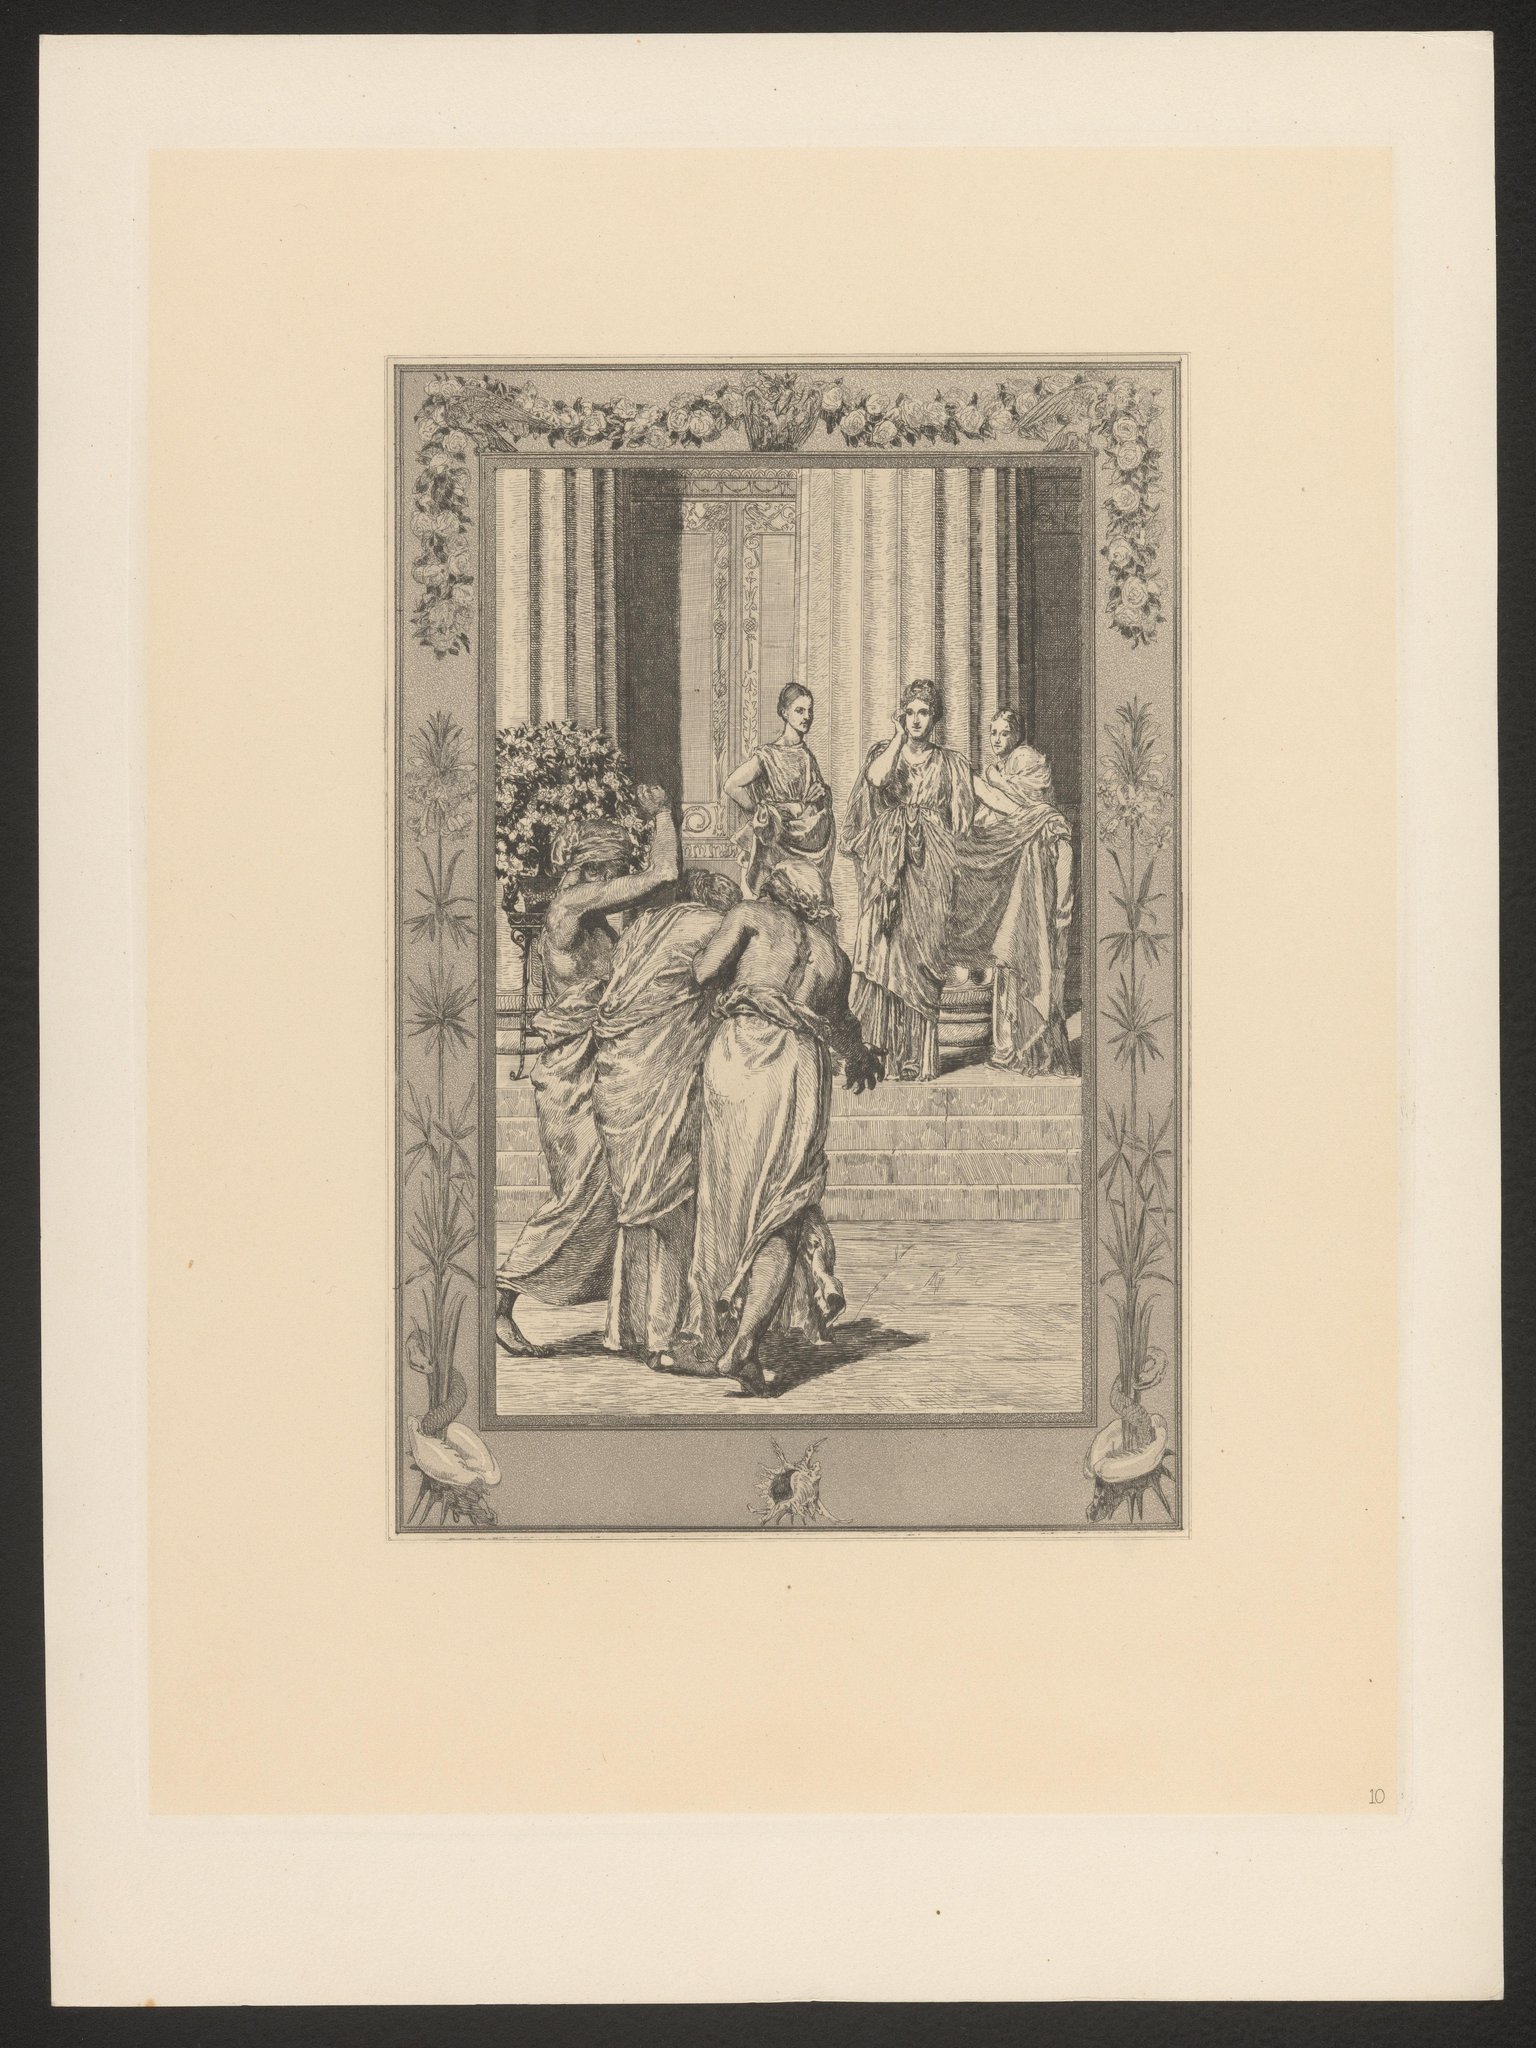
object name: print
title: Psyche und Venus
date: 1880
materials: paper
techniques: aquatint, etching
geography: nuremberg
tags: other scenes from the story of cupid and psyche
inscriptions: collector's mark: Lugt 2228